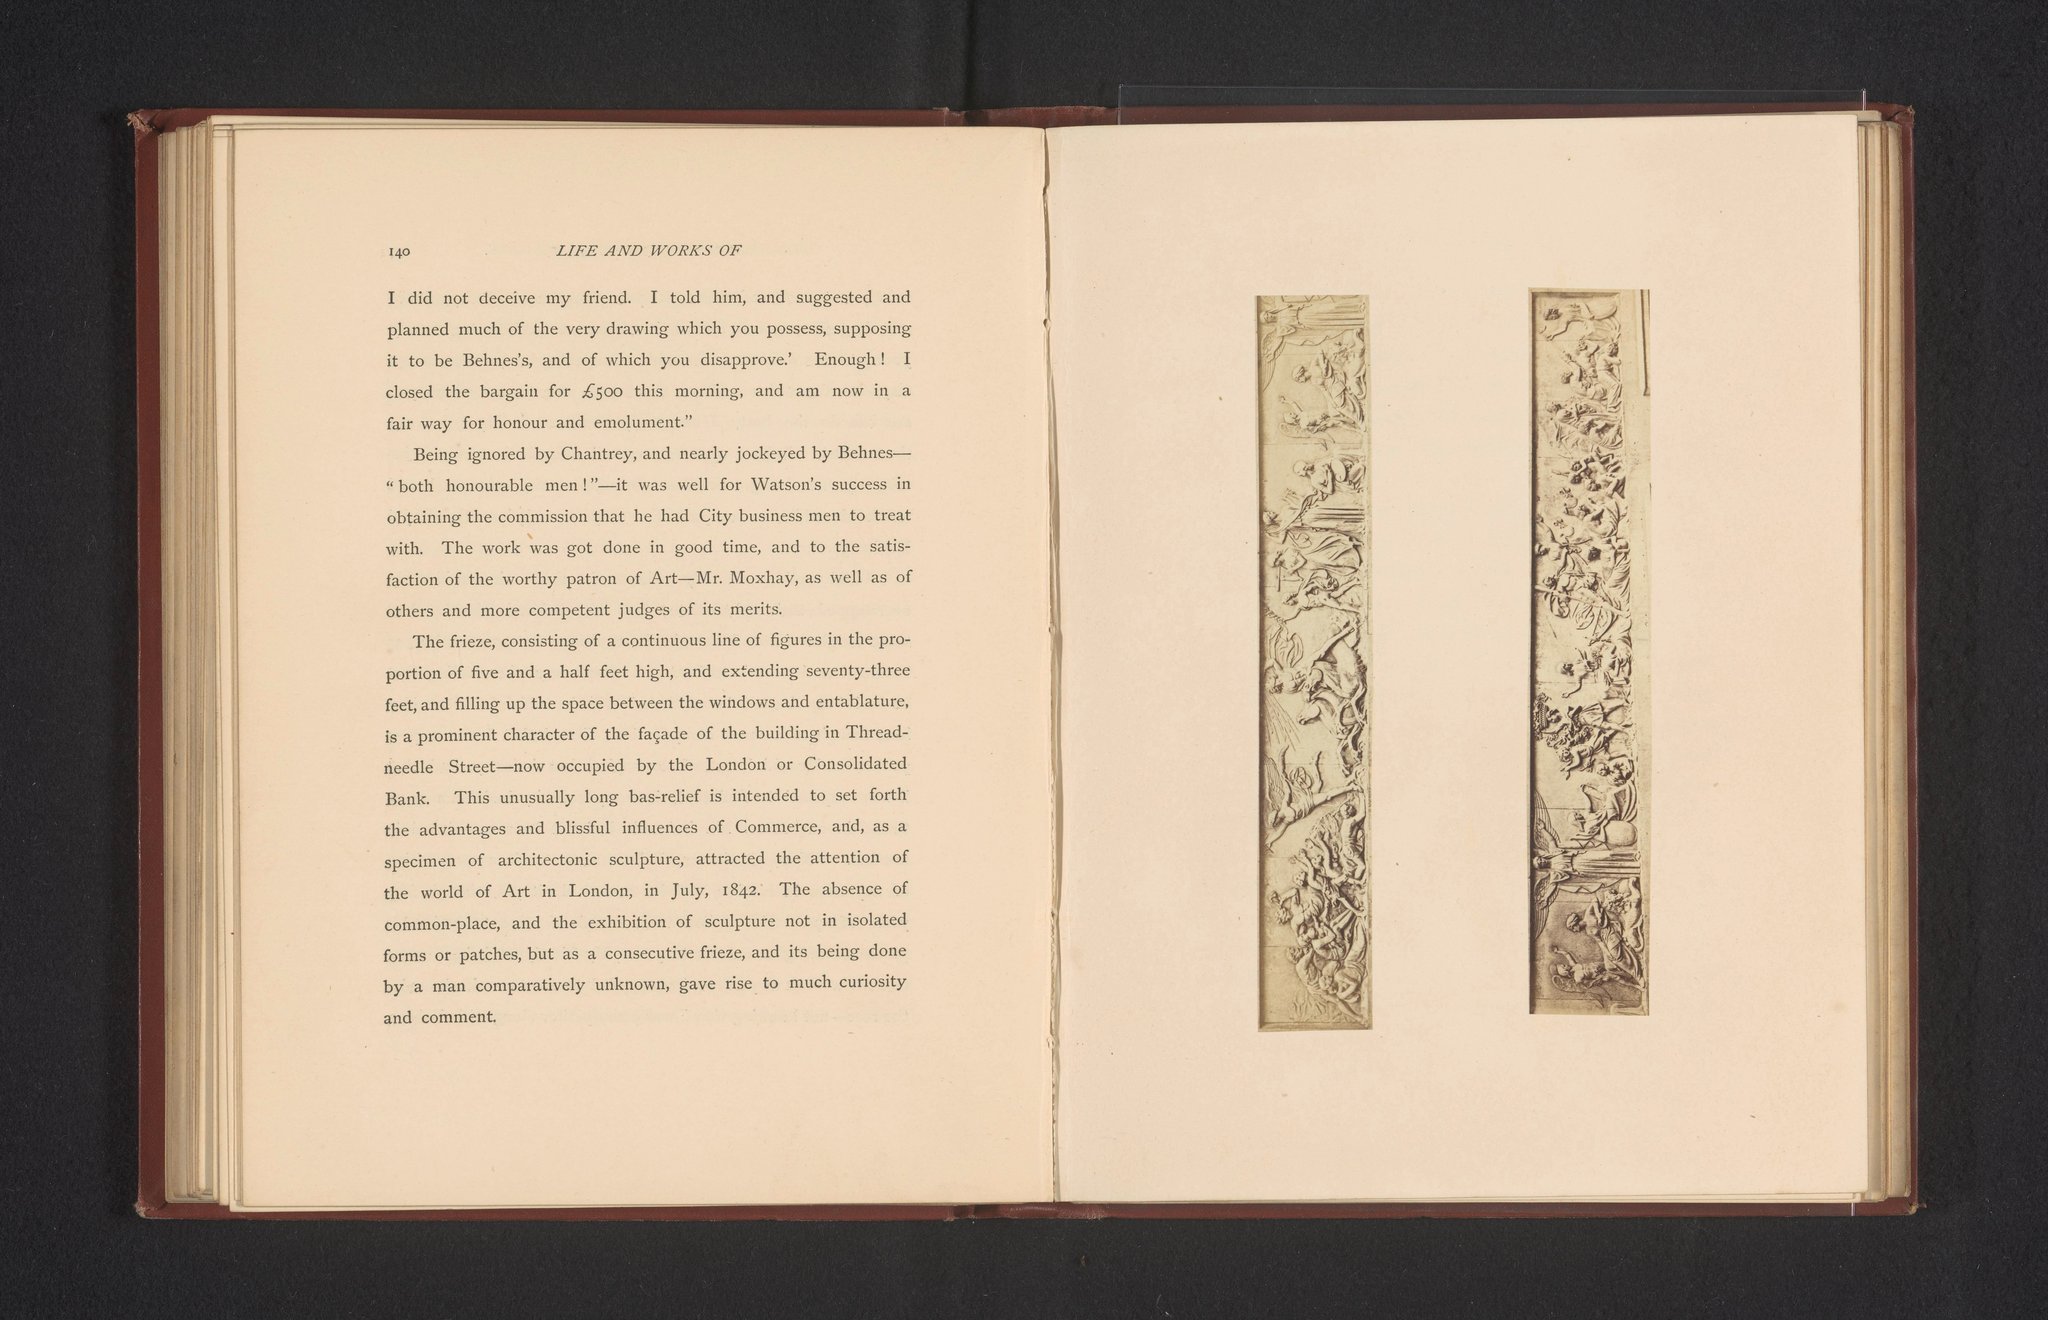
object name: page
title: Twee delen van een fries, voorstellende een allegorie op de handel en de vrede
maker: Anonymous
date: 1861-1866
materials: photographic support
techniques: albumen print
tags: symbols, allegories of peace, 'pax'; 'pace' (ripa), allegory of trade; 'commertio della vita humana' (ripa), sculpture (+ relief ~ sculpture)